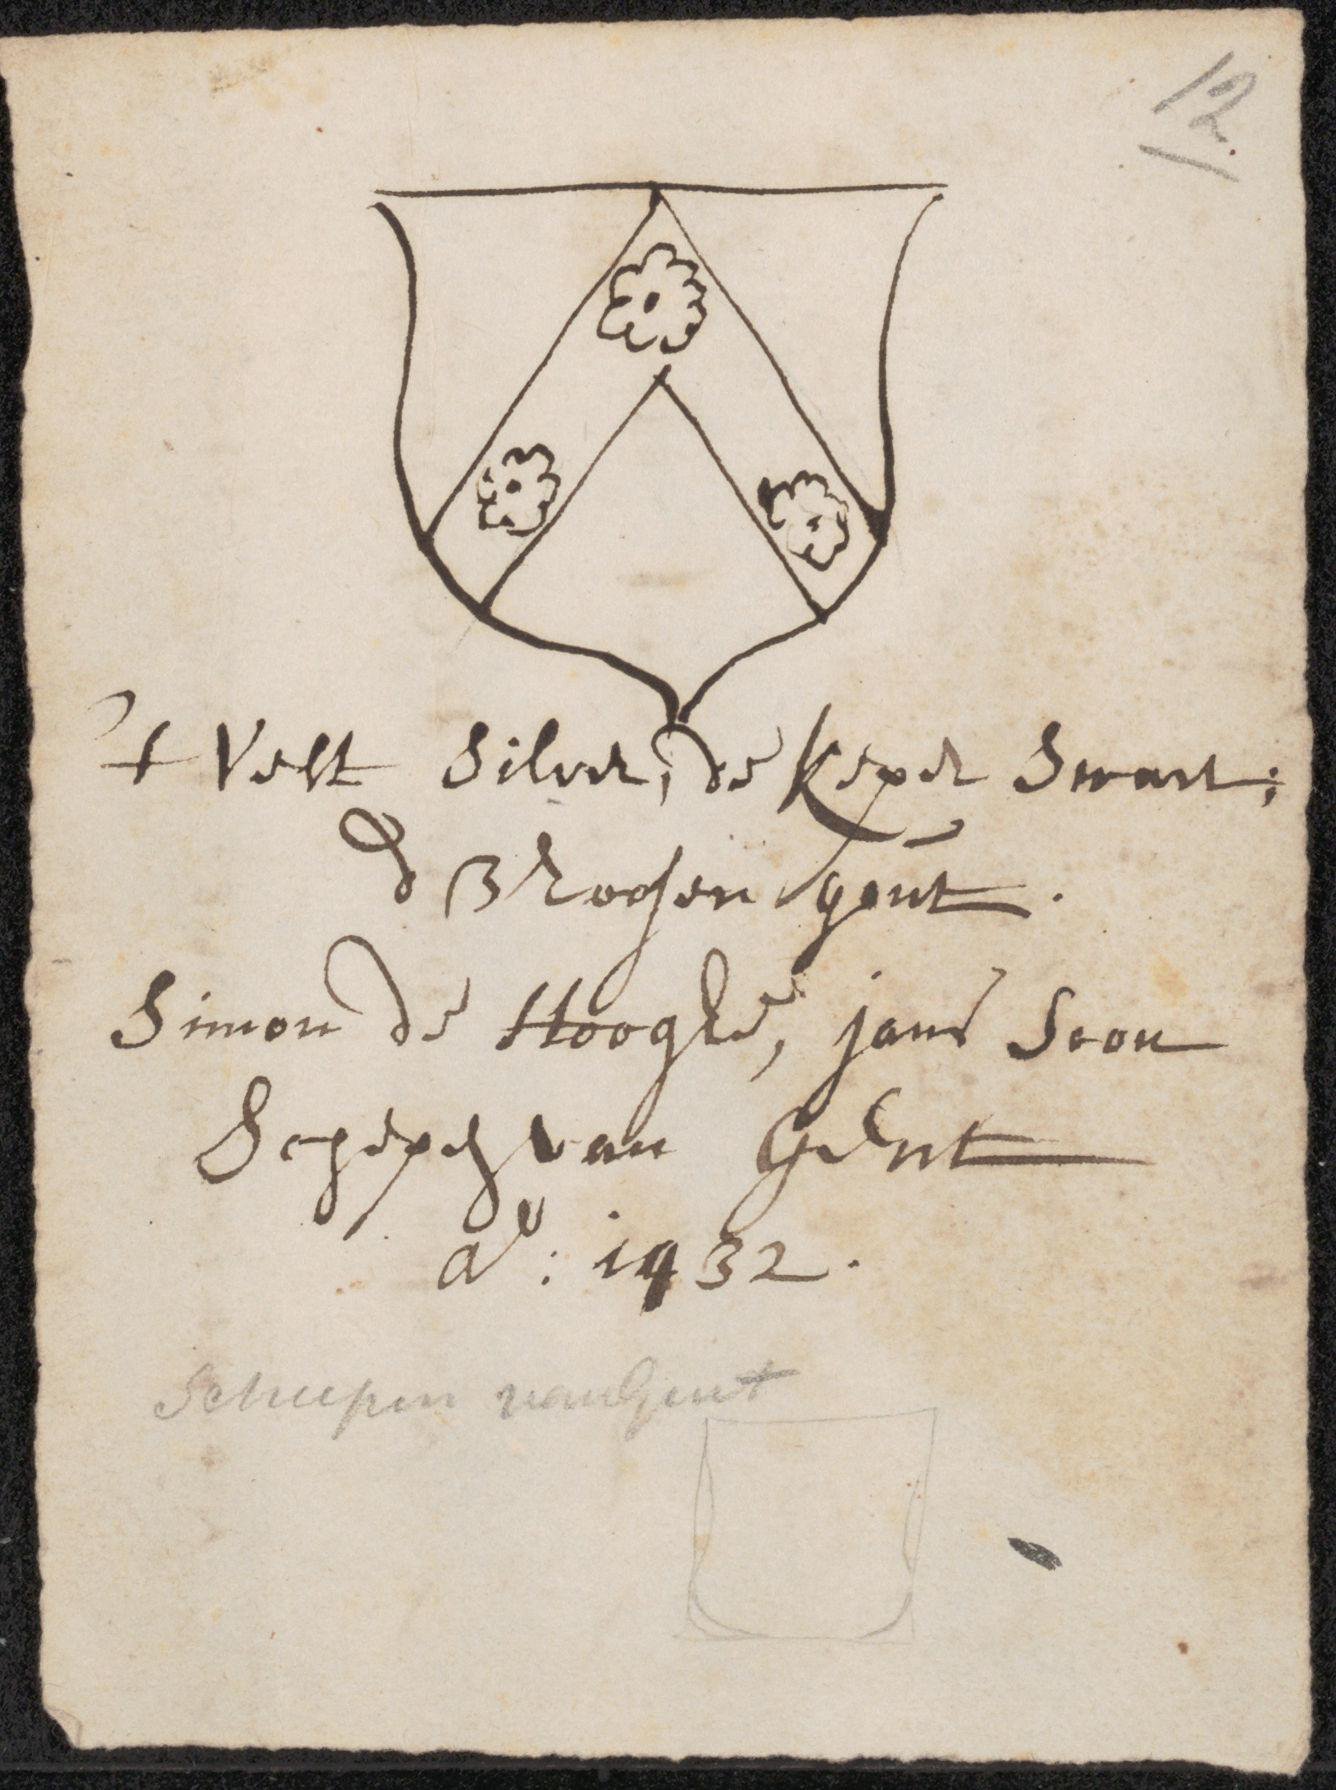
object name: manuscript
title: Wapenschild voor Simon de Hooghe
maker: Anonymous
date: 1625-1699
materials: ink, paper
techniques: pen, writing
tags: armorial bearing, heraldry, ghent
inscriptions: collector's mark: Lugt 2233, watermark